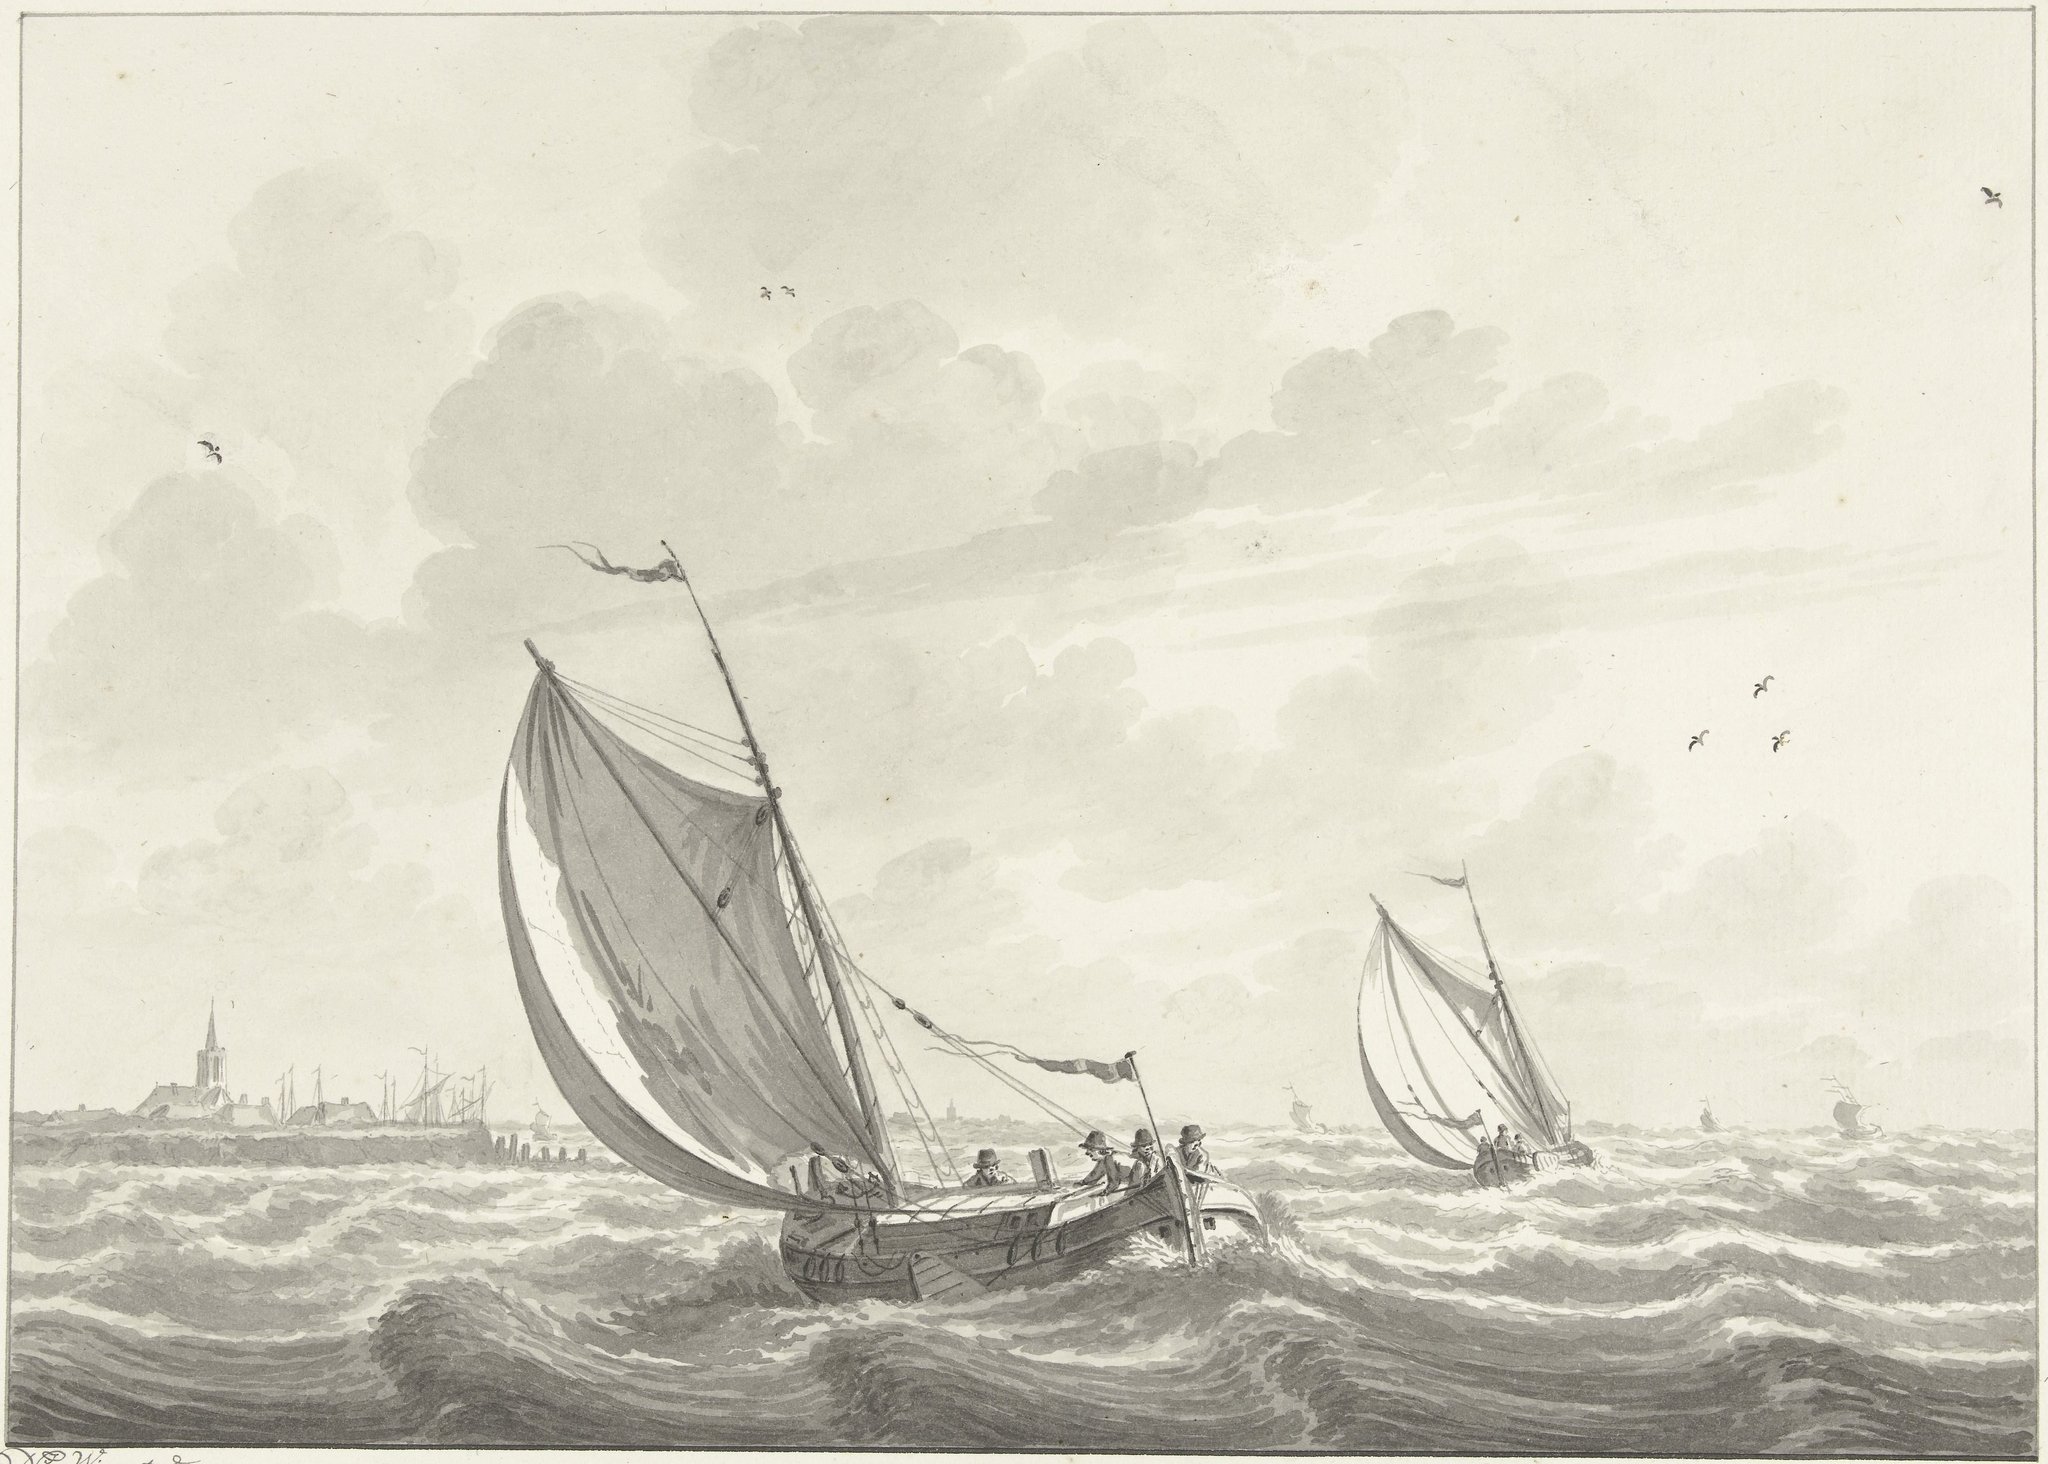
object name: drawing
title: Schip onder zeil op de Maas, in de verte de dorpen Oud en Nieuw Beijerland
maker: nicolaas wicart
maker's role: draughtsman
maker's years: 1748-1815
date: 1758-1815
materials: ink, paper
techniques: brush, pen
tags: sailing-ship, sailing-boat, river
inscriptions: inscription: ‘de dorpe Oud, en Nieuwbeyerland, aan de Maas’